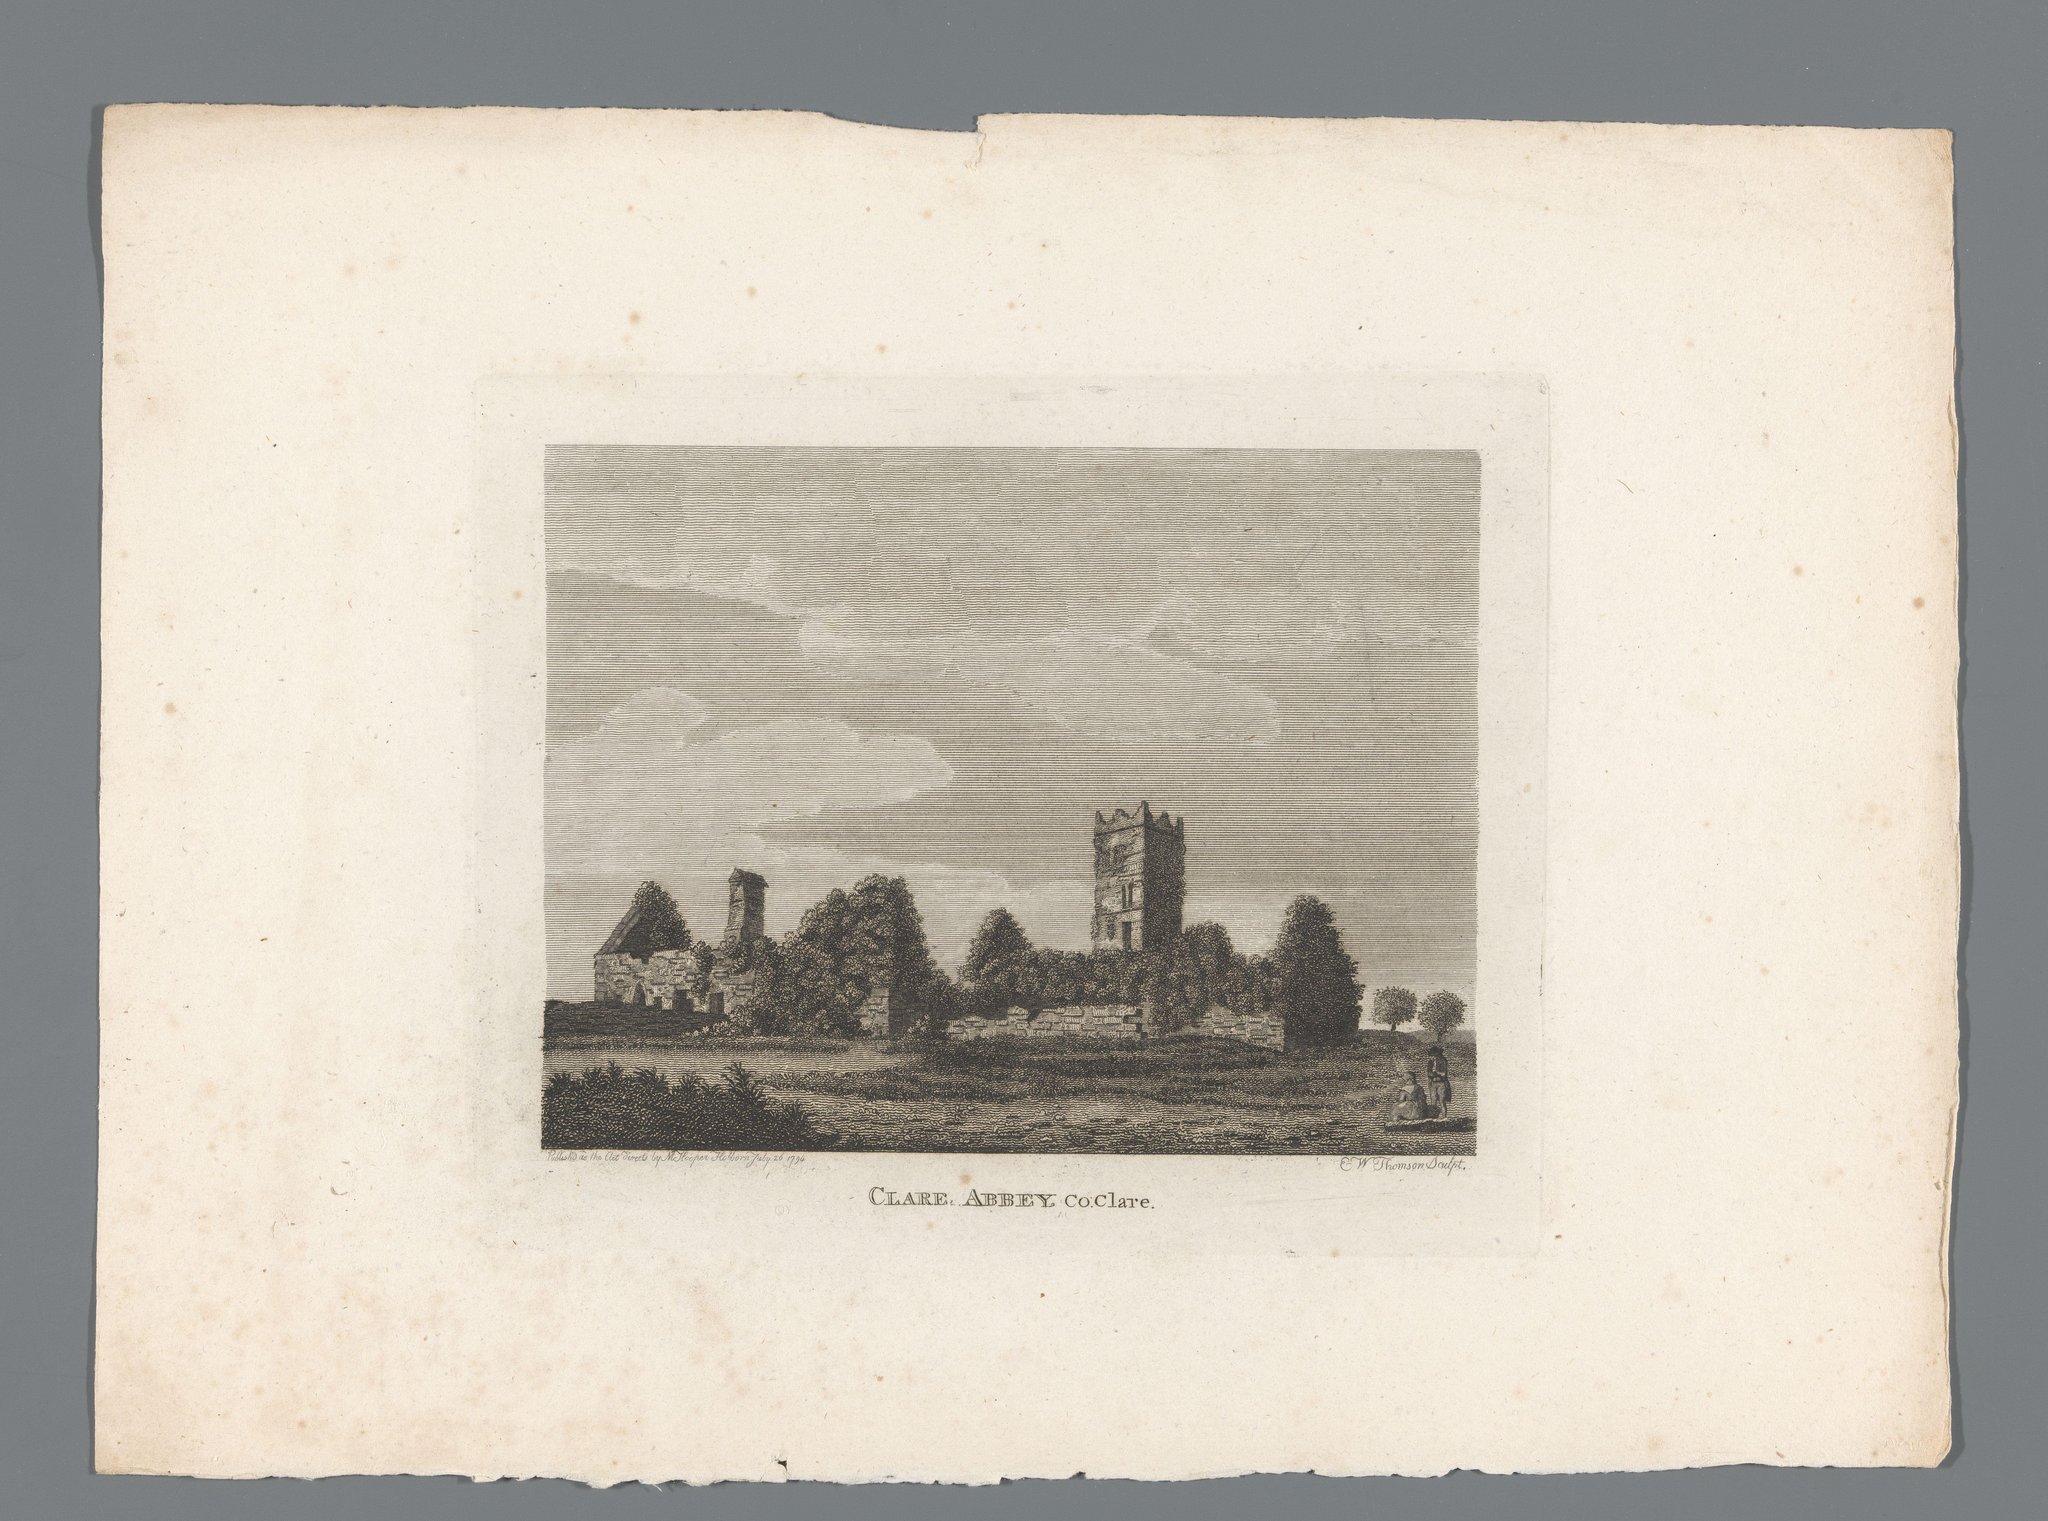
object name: print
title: Gezicht op de ruïnes van de abdij van Clare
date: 1794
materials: paper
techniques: etching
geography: london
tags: abbey, monastery, convent ~ roman catholic church, landscape with ruins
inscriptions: date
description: Prent verschenen in: Grose, Francis. The antiquities of Ireland. Londen: S. Hooper, 1795, dl. 2.